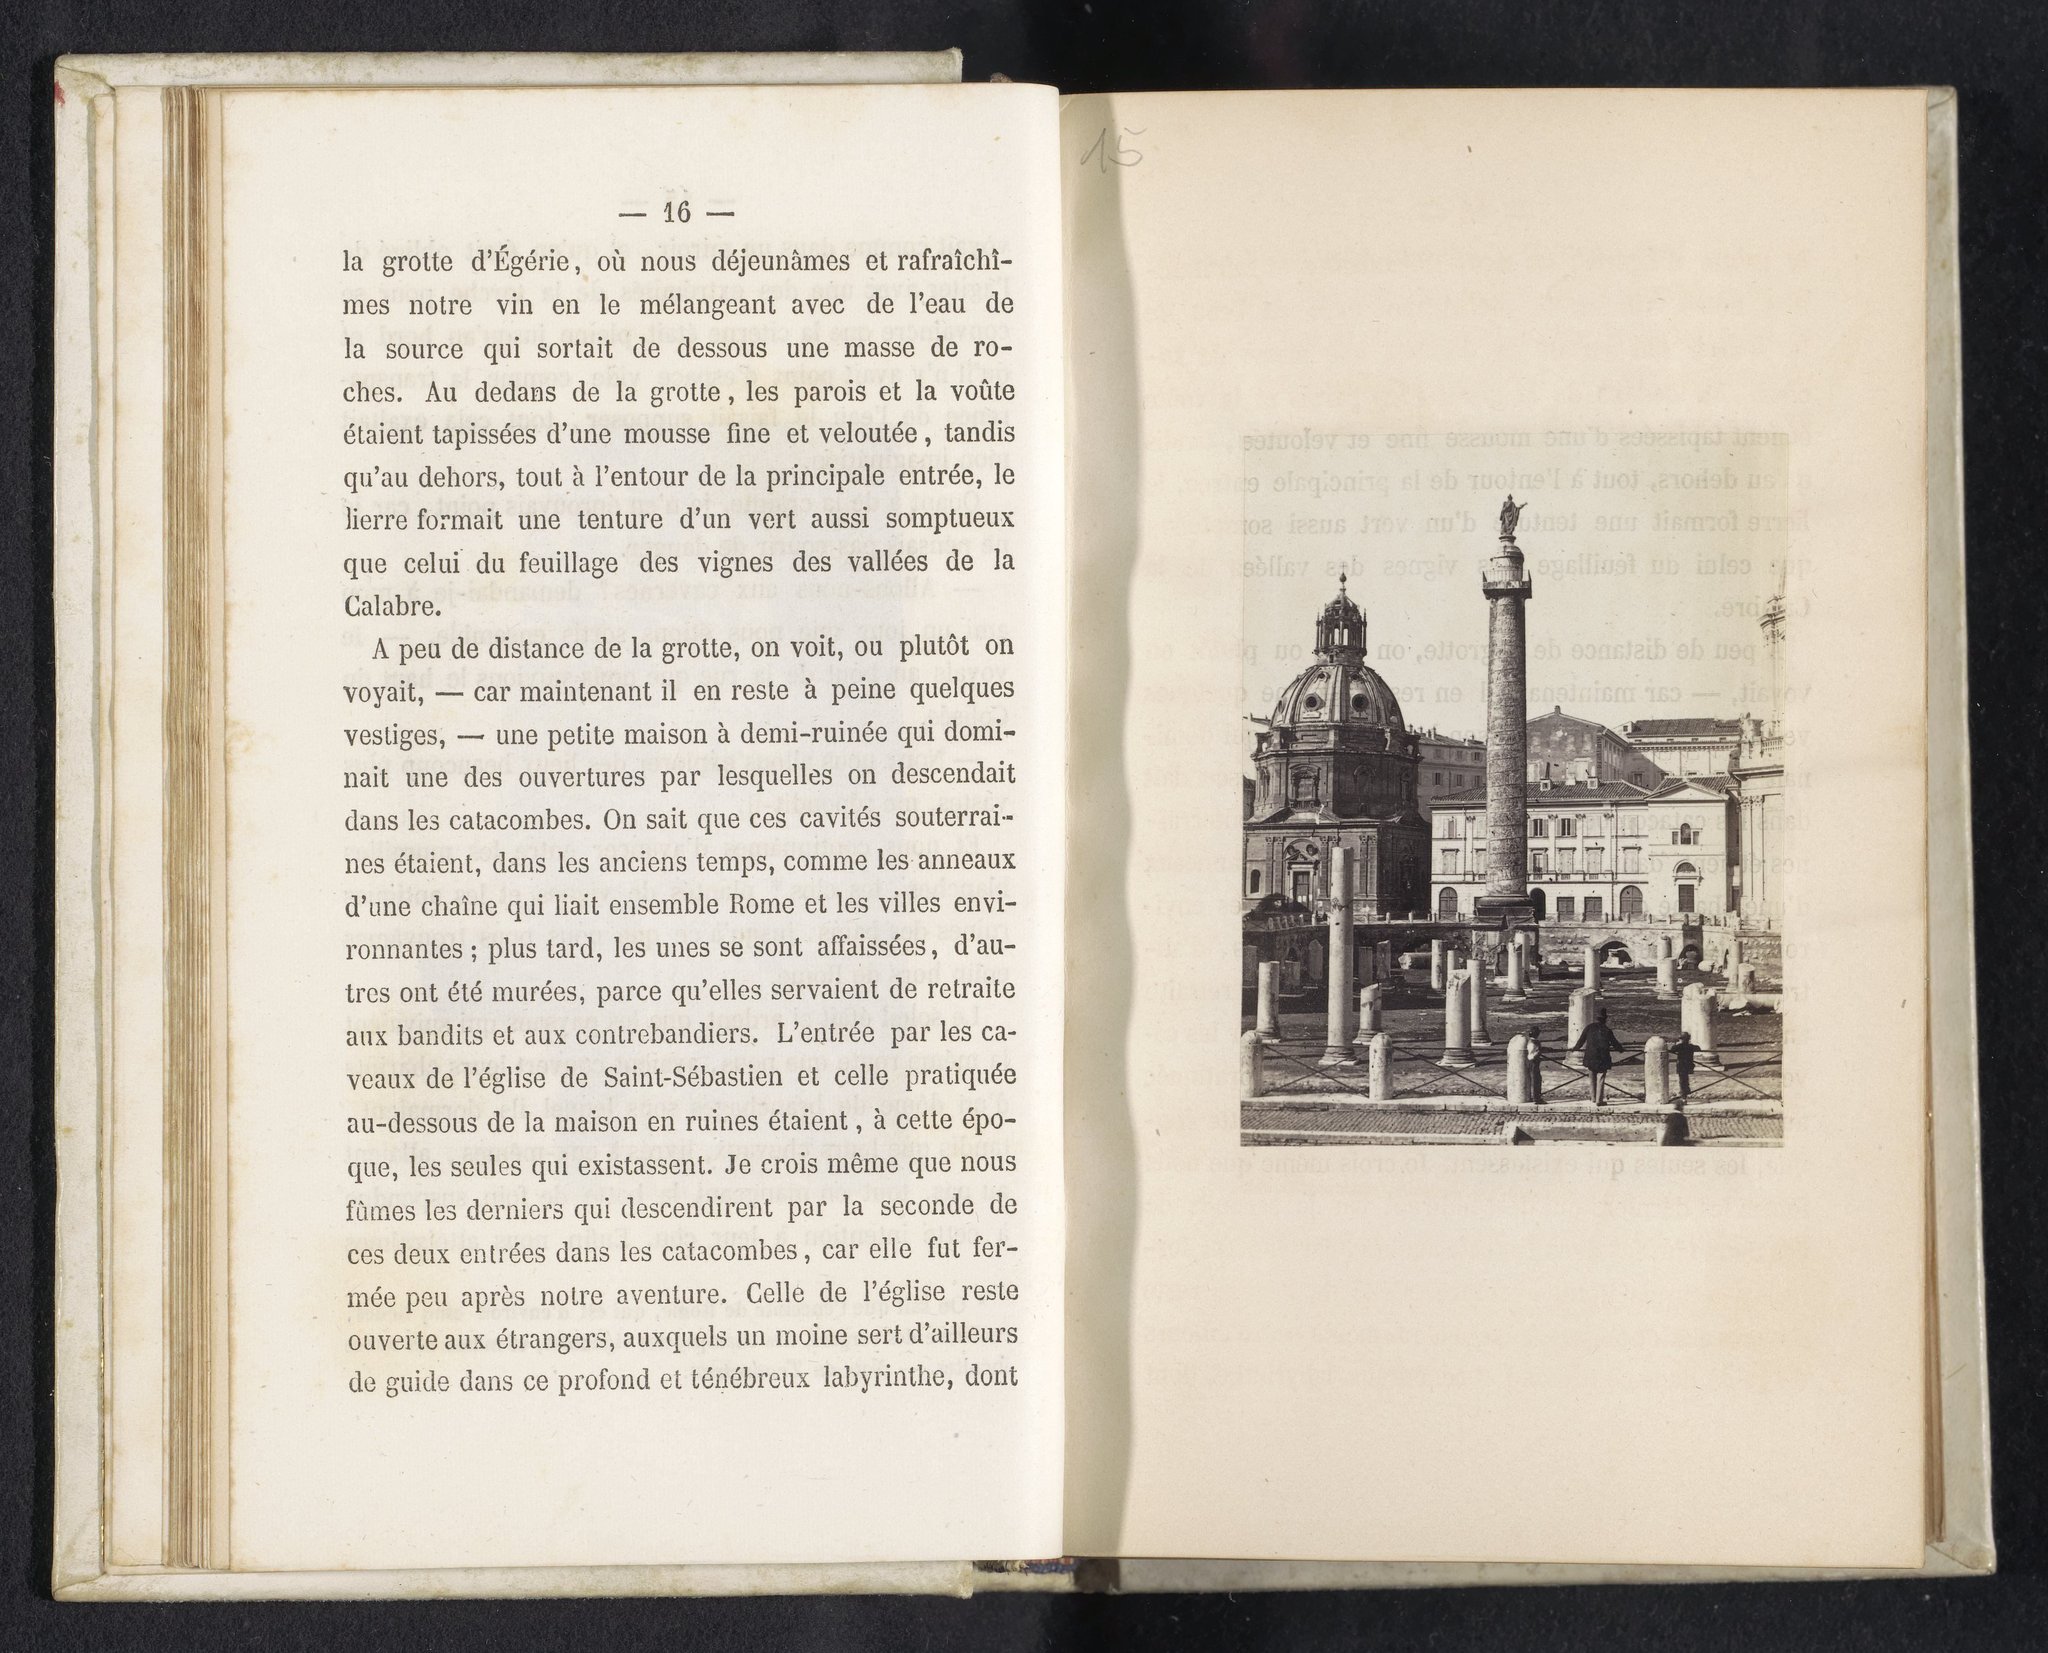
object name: page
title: Zuil van Marcus Aurelius op de Piazza Colonna te Rome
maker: Anonymous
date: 1850-1860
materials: photographic support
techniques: albumen print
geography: piazza colonna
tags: triumphal column with helical friezes